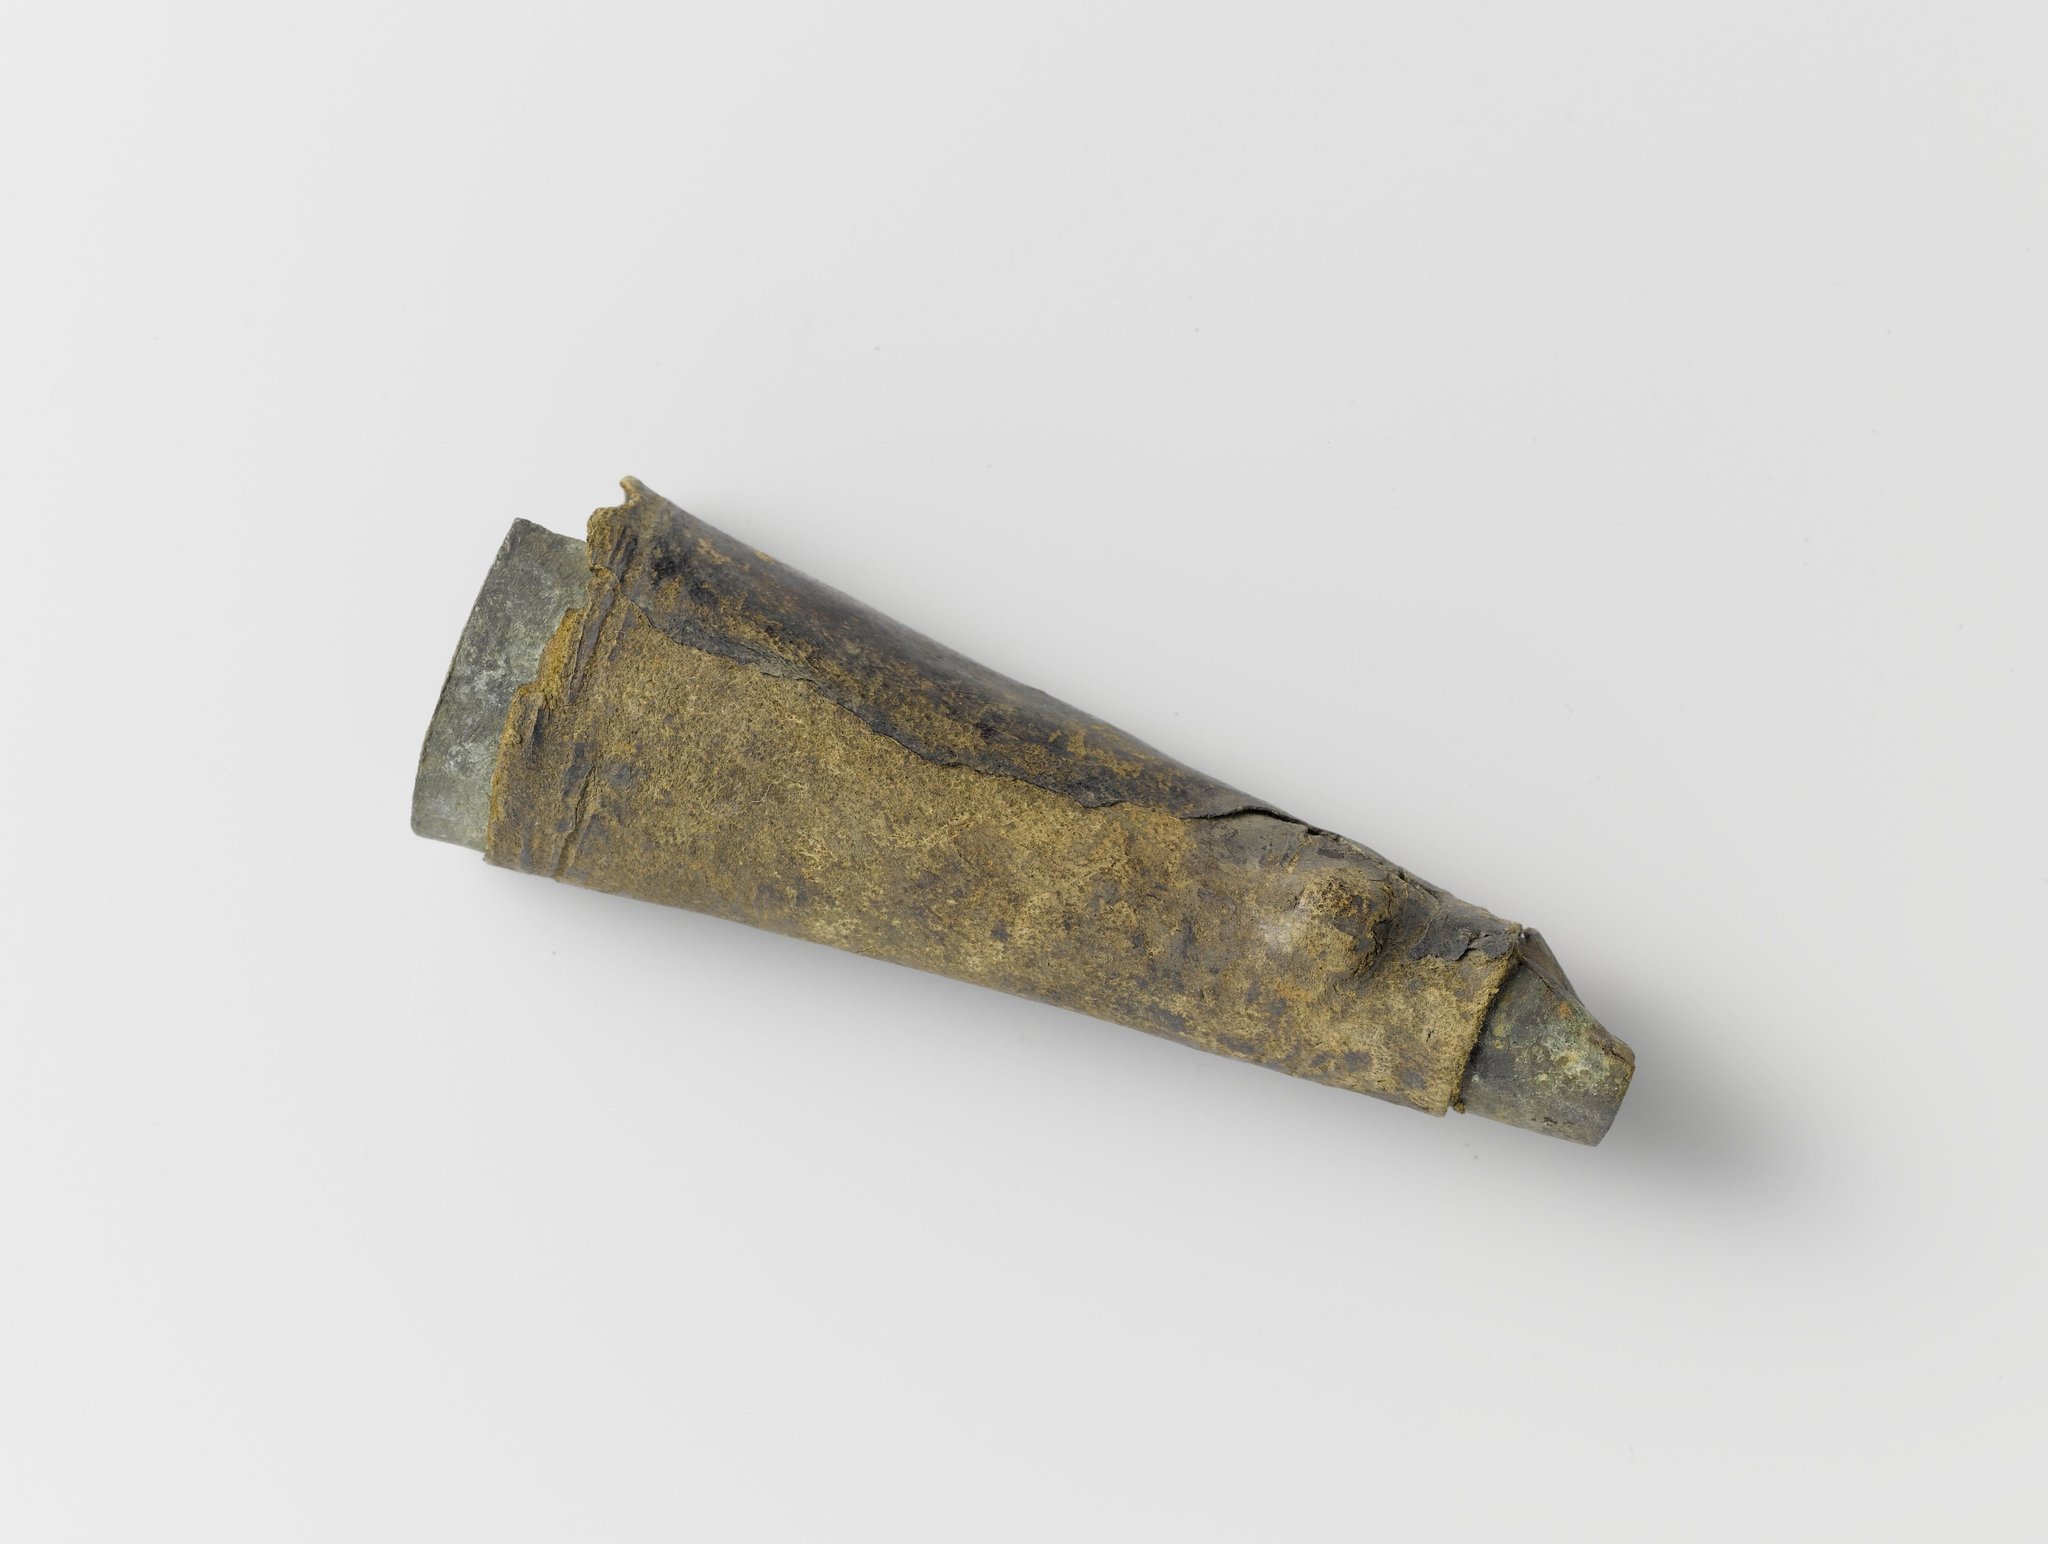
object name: kruitmaat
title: Musketmaat met oortjes, zonder onderkant en dop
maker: Anonymous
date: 1590-1596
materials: brass, leather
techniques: striking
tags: willem barendsz., amsterdam, jacob van heemskerck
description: Musketmaat met oortjes, zonder onderkant en dop.